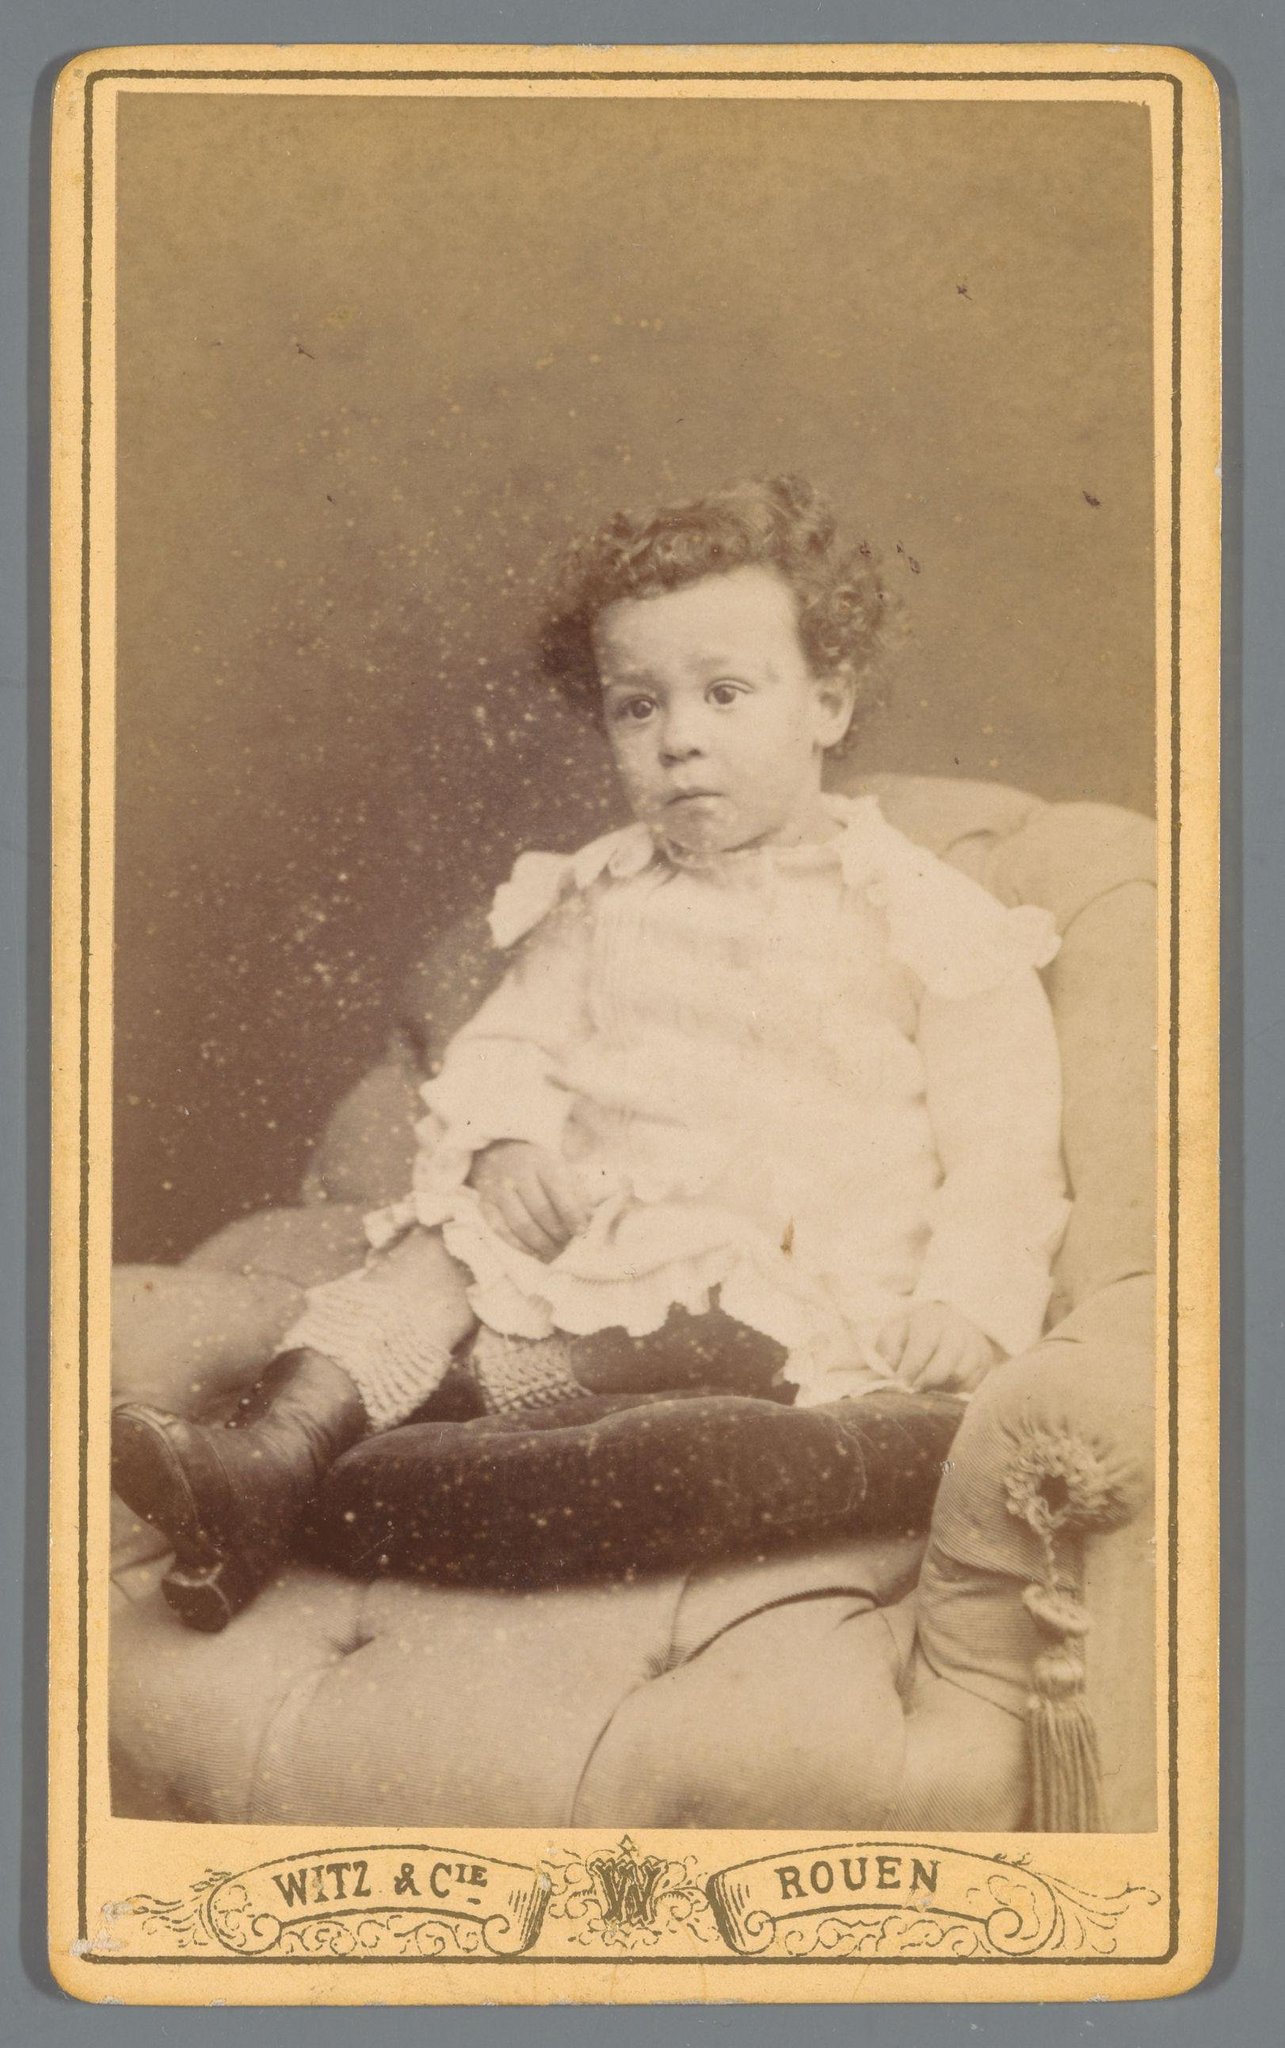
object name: photograph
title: Portret van André Lemaistre, 20 maanden oud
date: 1855-1885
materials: cardboard, paper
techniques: albumen print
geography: rouen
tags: historical persons, infant, baby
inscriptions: address: ‘ROUEN/ Place des Carmes, 46’, number: ‘No 96216’, inscription: ‘André Lemaistre/ 20 Mois’, inscription: ‘Tous les cliches sont conservés’